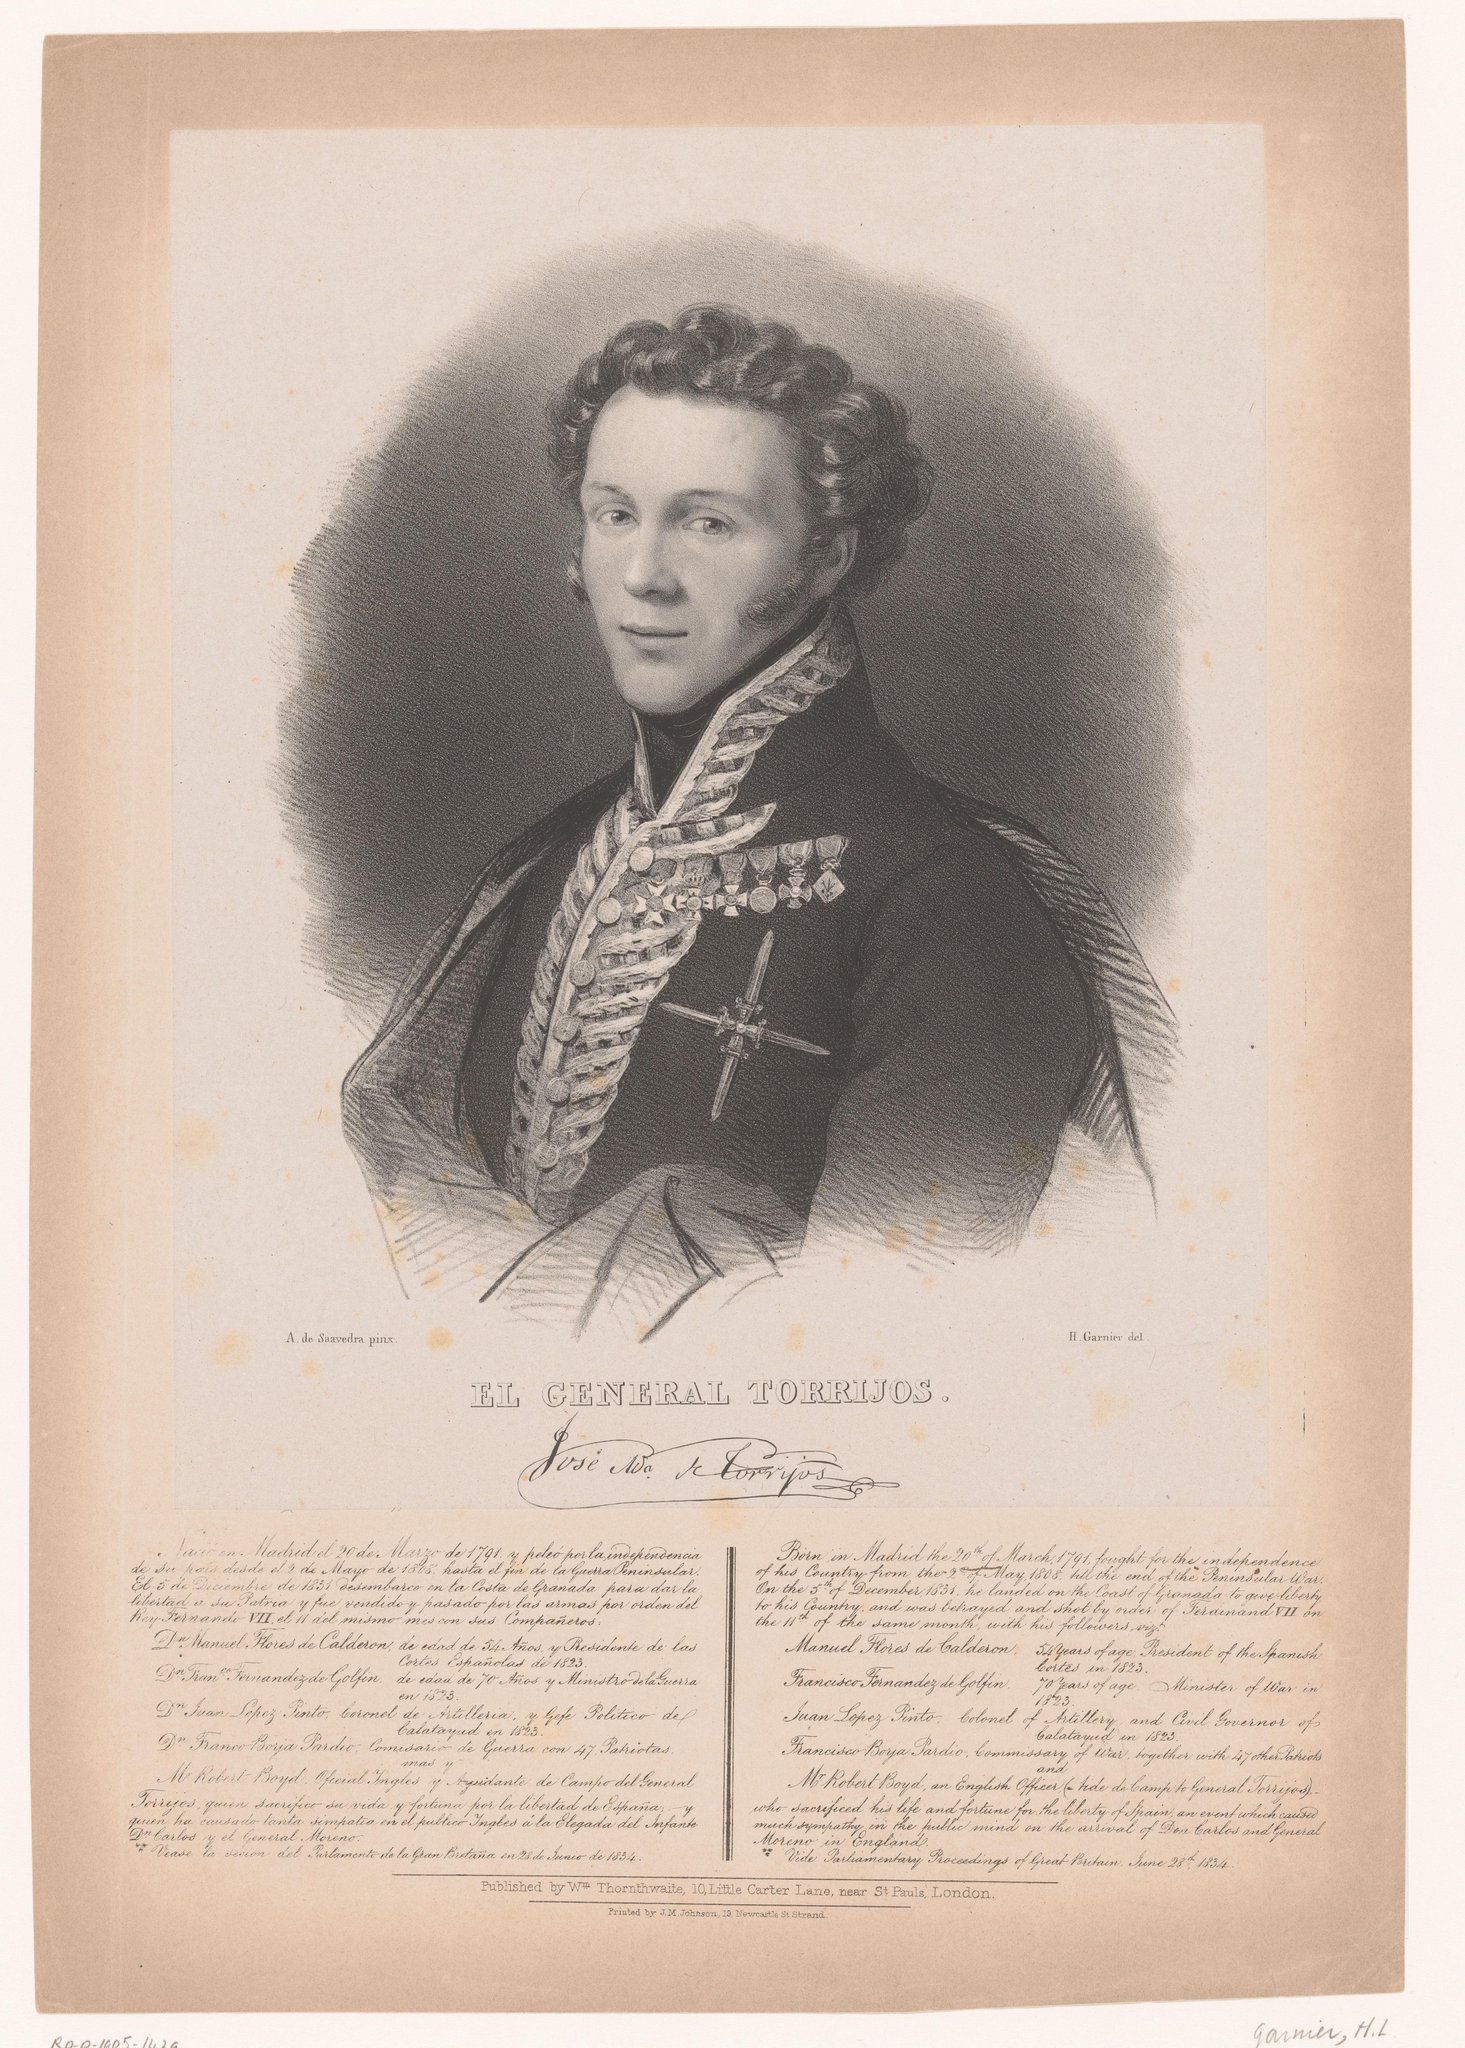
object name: print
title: El General Torrijos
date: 1834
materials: paper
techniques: lithograph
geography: london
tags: historical persons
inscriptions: collector's mark: Lugt 2228a